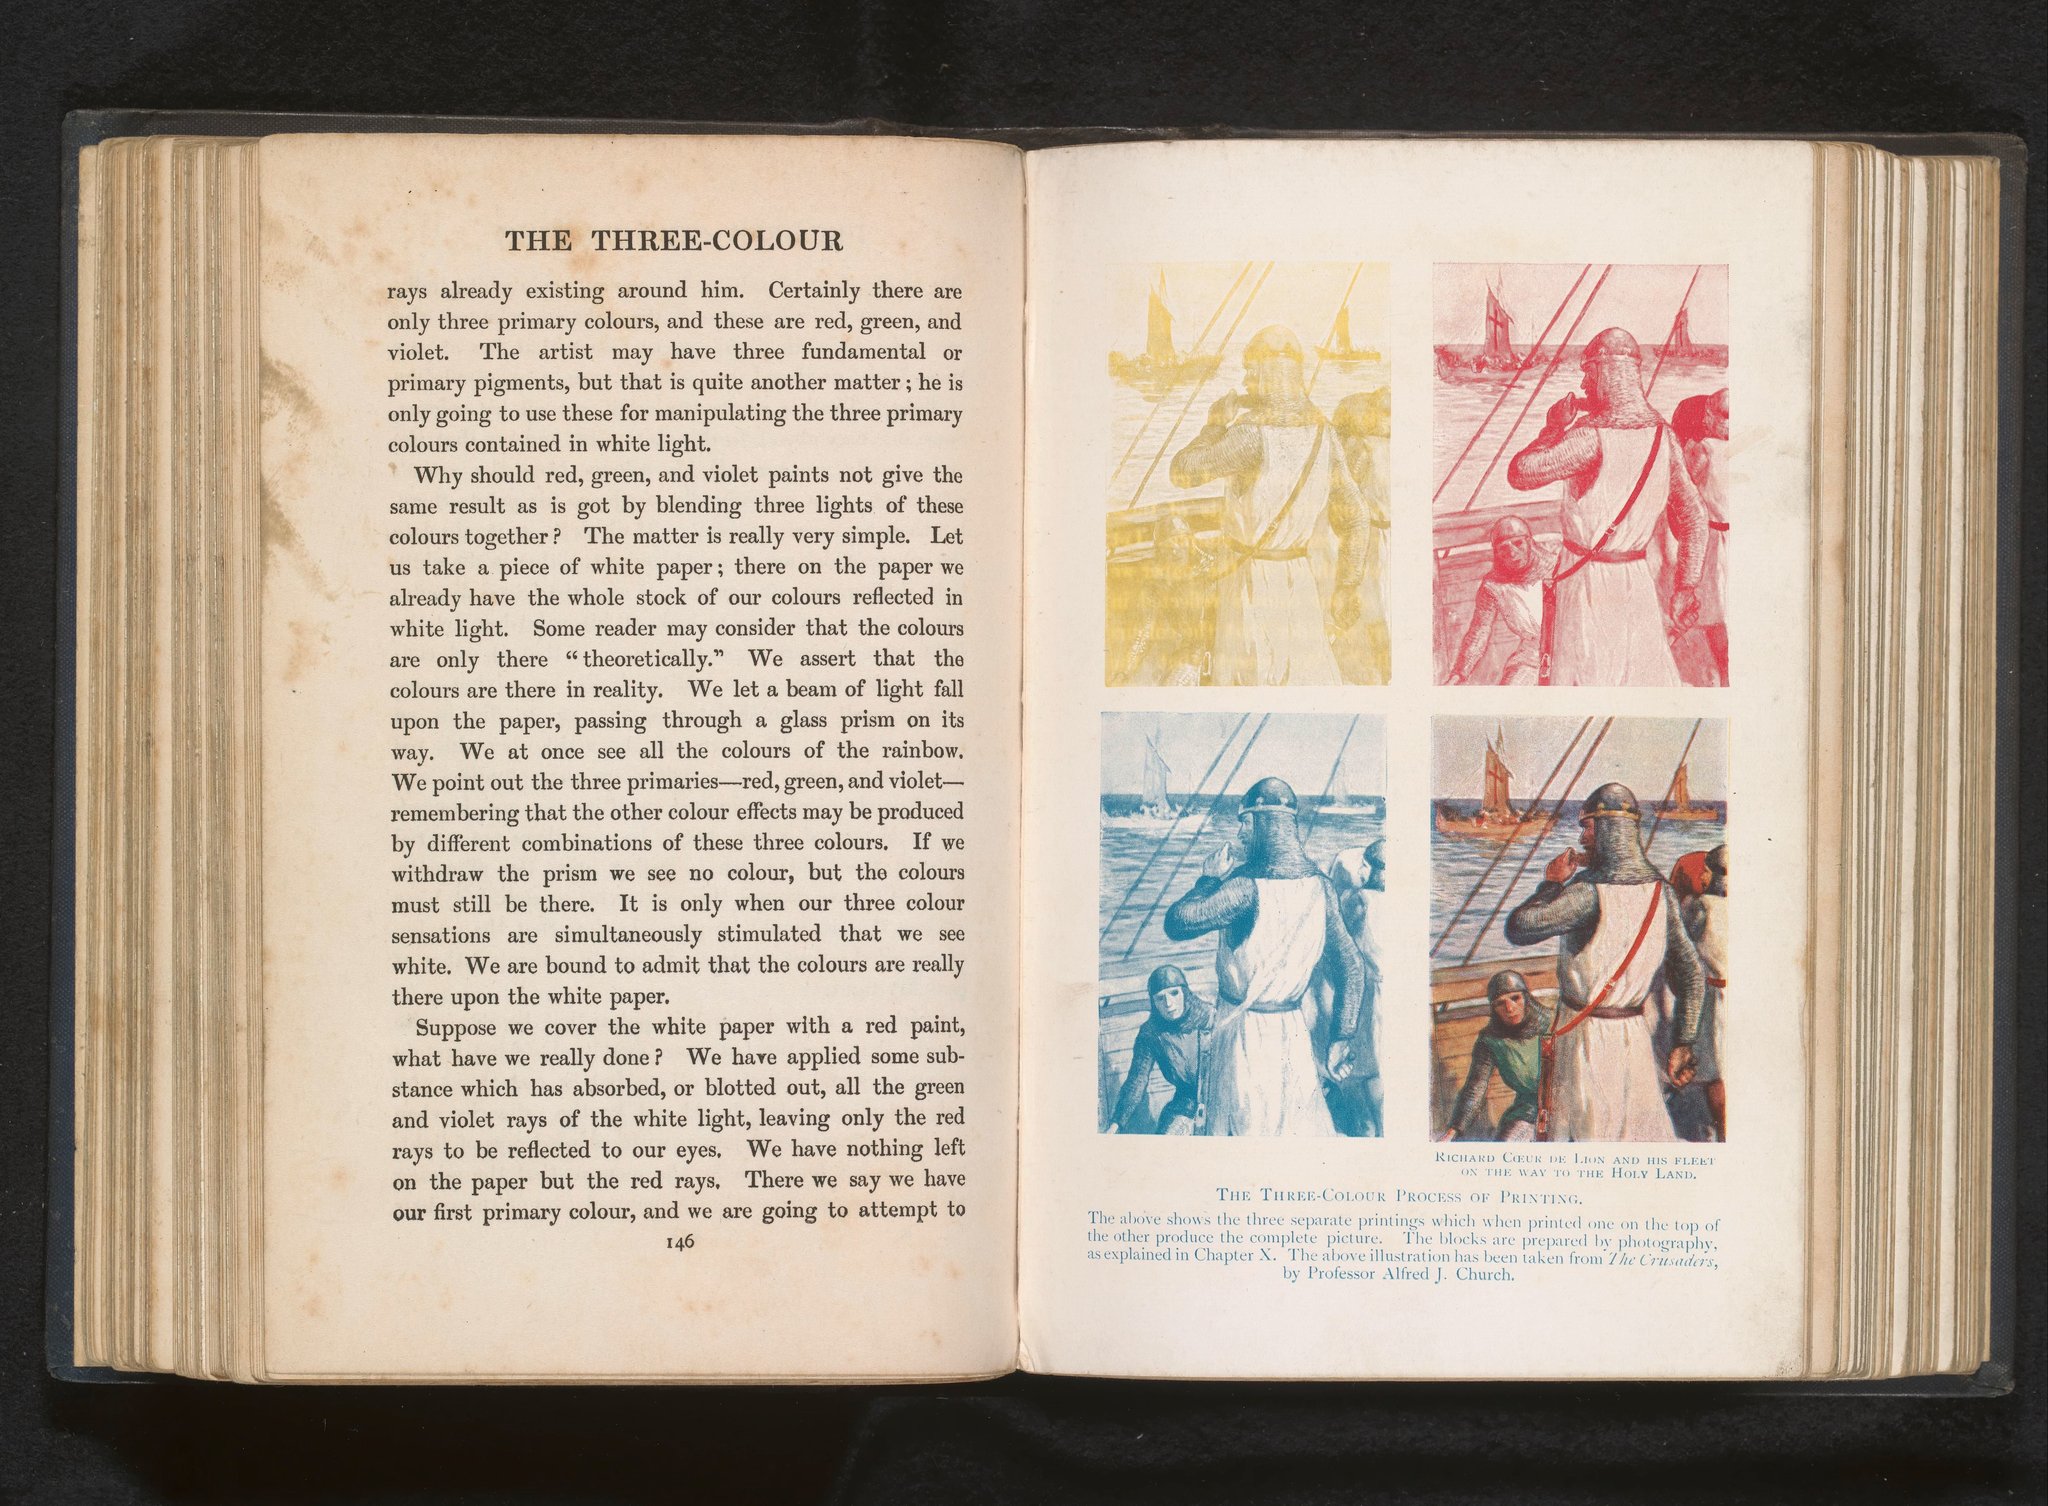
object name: photomechanical print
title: The three-colour process of printing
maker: Anonymous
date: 1898-1908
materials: paper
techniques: autotype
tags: sailing-ship, sailing-boat, commander-in-chief, admiral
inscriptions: inscription: ‘The above shows the three separate printings which when printed one on top of the other produce the complete picture. The blocks are prepared by photography, as explained in Chapter X. The above illustration has been taken from The Crusaders by Professor Alfred J. Church.’